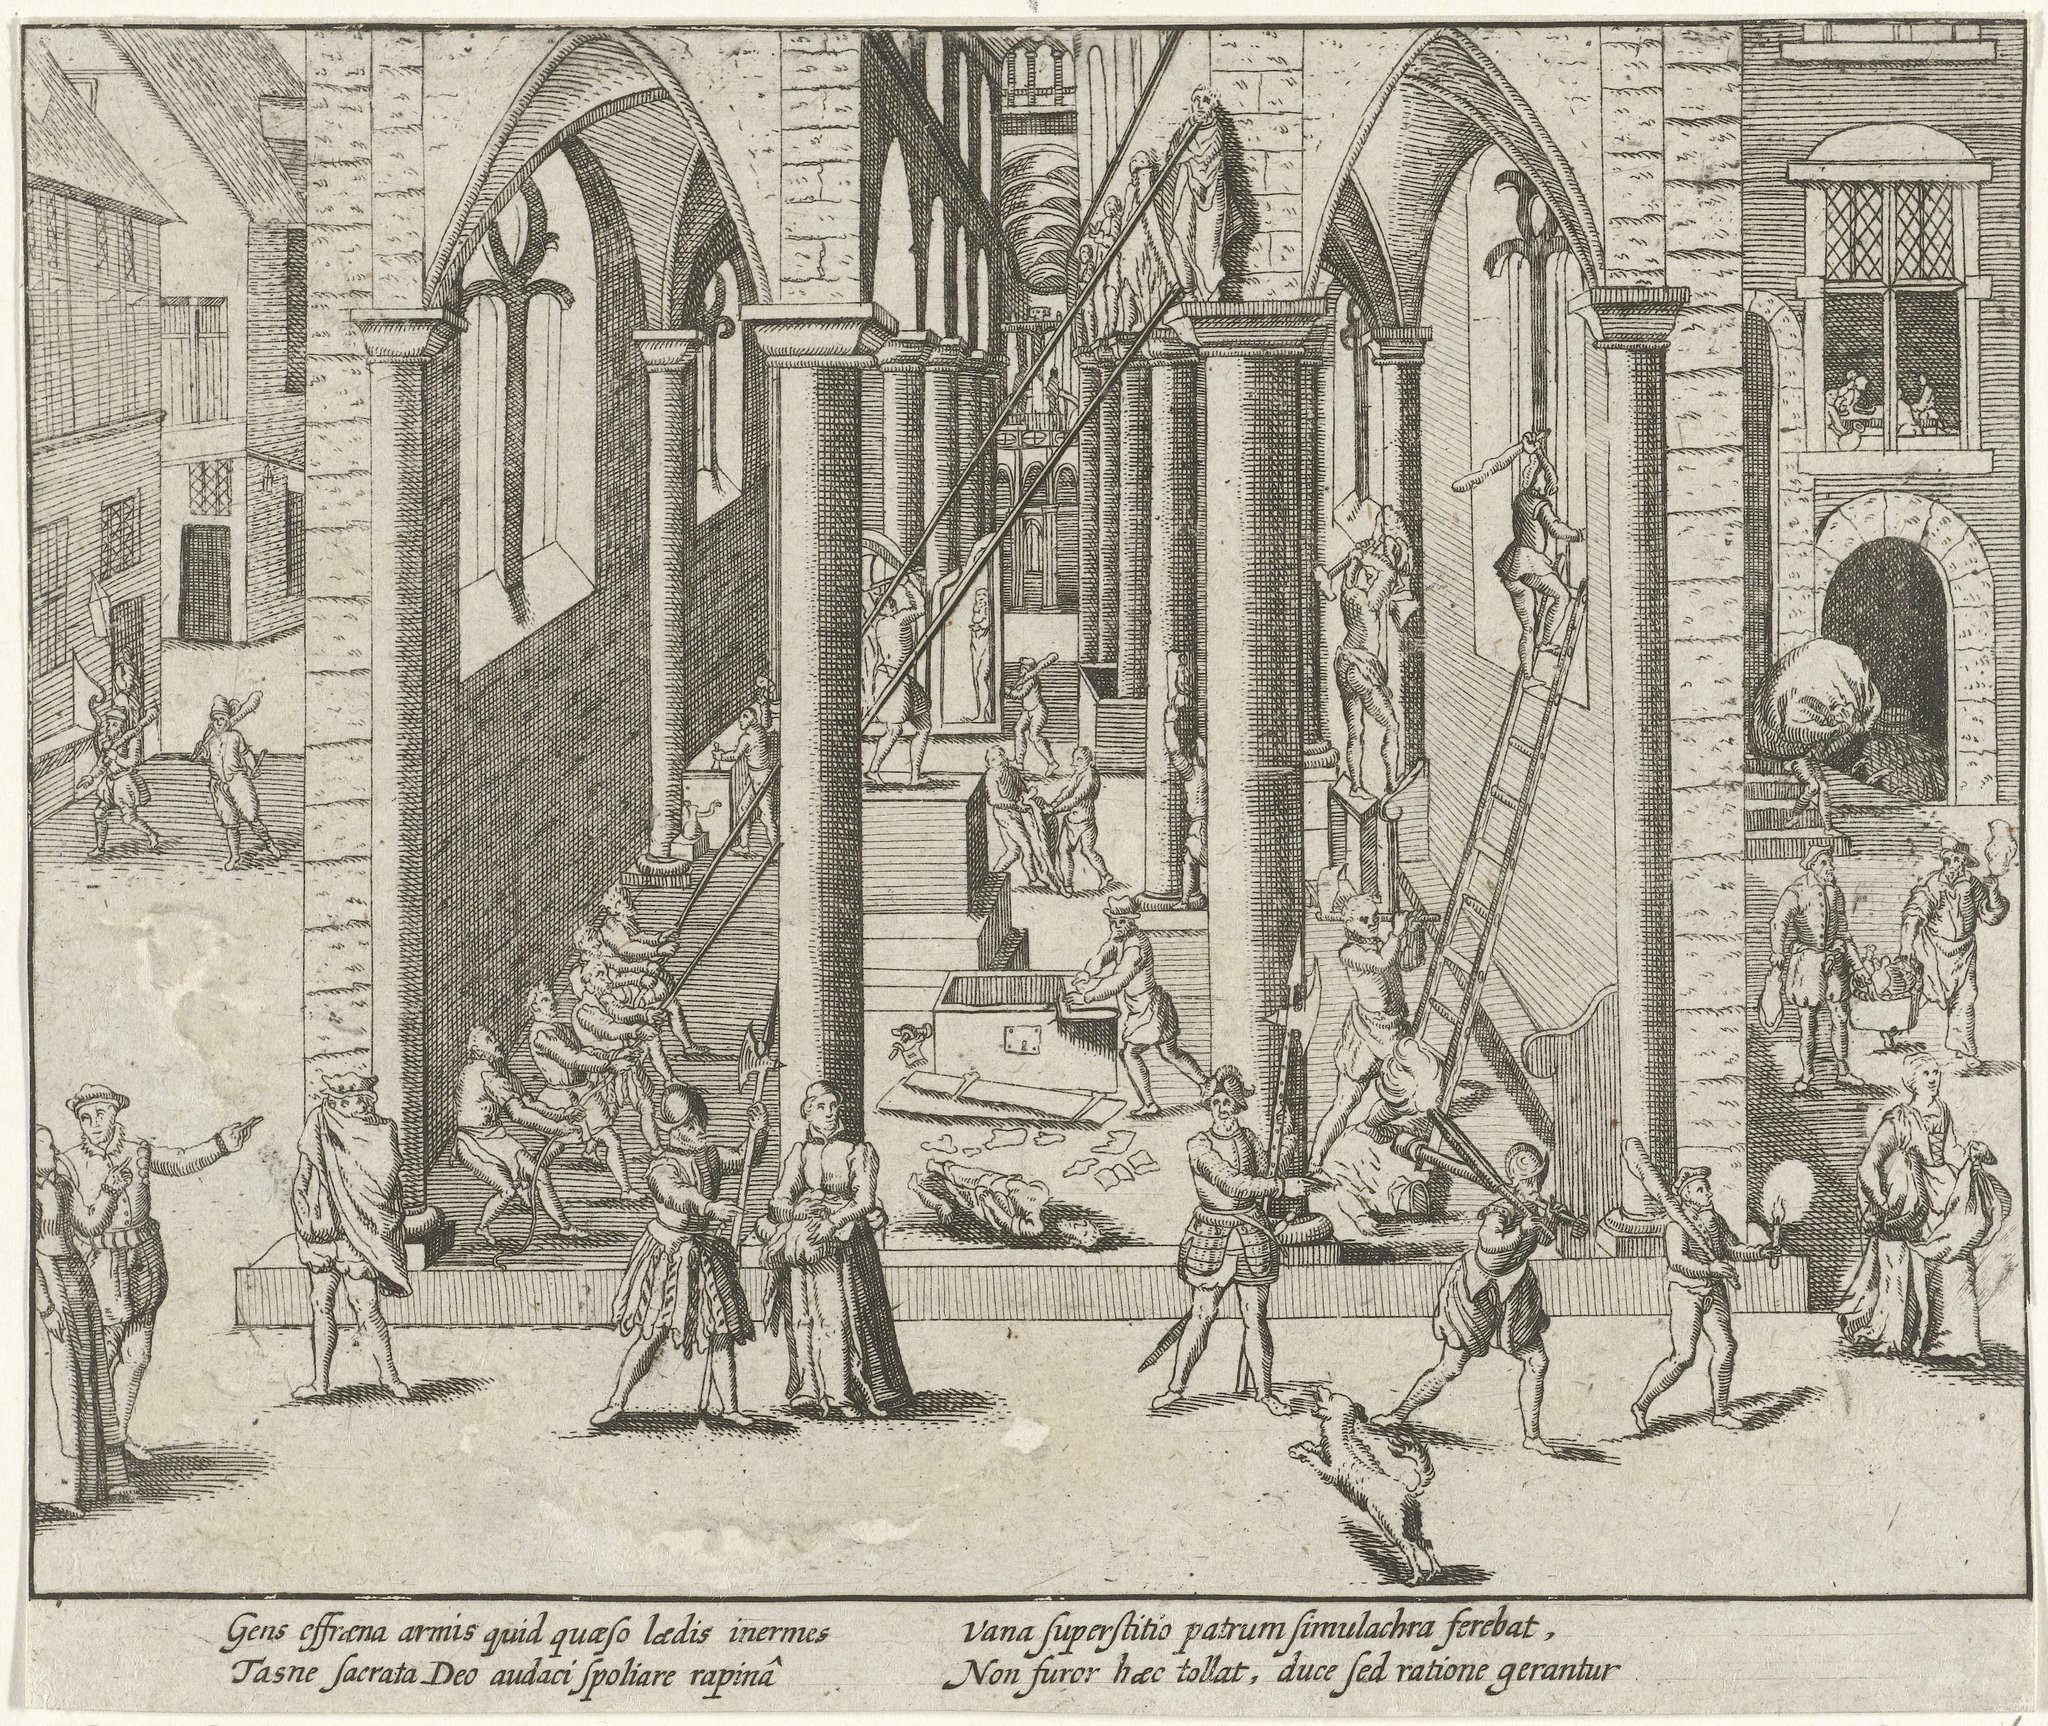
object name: print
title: Beeldenstorm, 1566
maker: Anonymous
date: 1613-1615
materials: paper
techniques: etching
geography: northern netherlands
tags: iconoclasm, beeldenstorm (1566)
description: Beeldenstorm, 20 augustus 1566. Gezicht in een kerk waar mannen heiligenbeelden omver trekken, ramen inslaan en schilderijen vernielen. Soldaten kijken toe, rechts wordt geplunderd en geroofd. Met onderschrift van 4 regels in het Latijn. Zonder nummer. Onbedrukt op achterzijde.